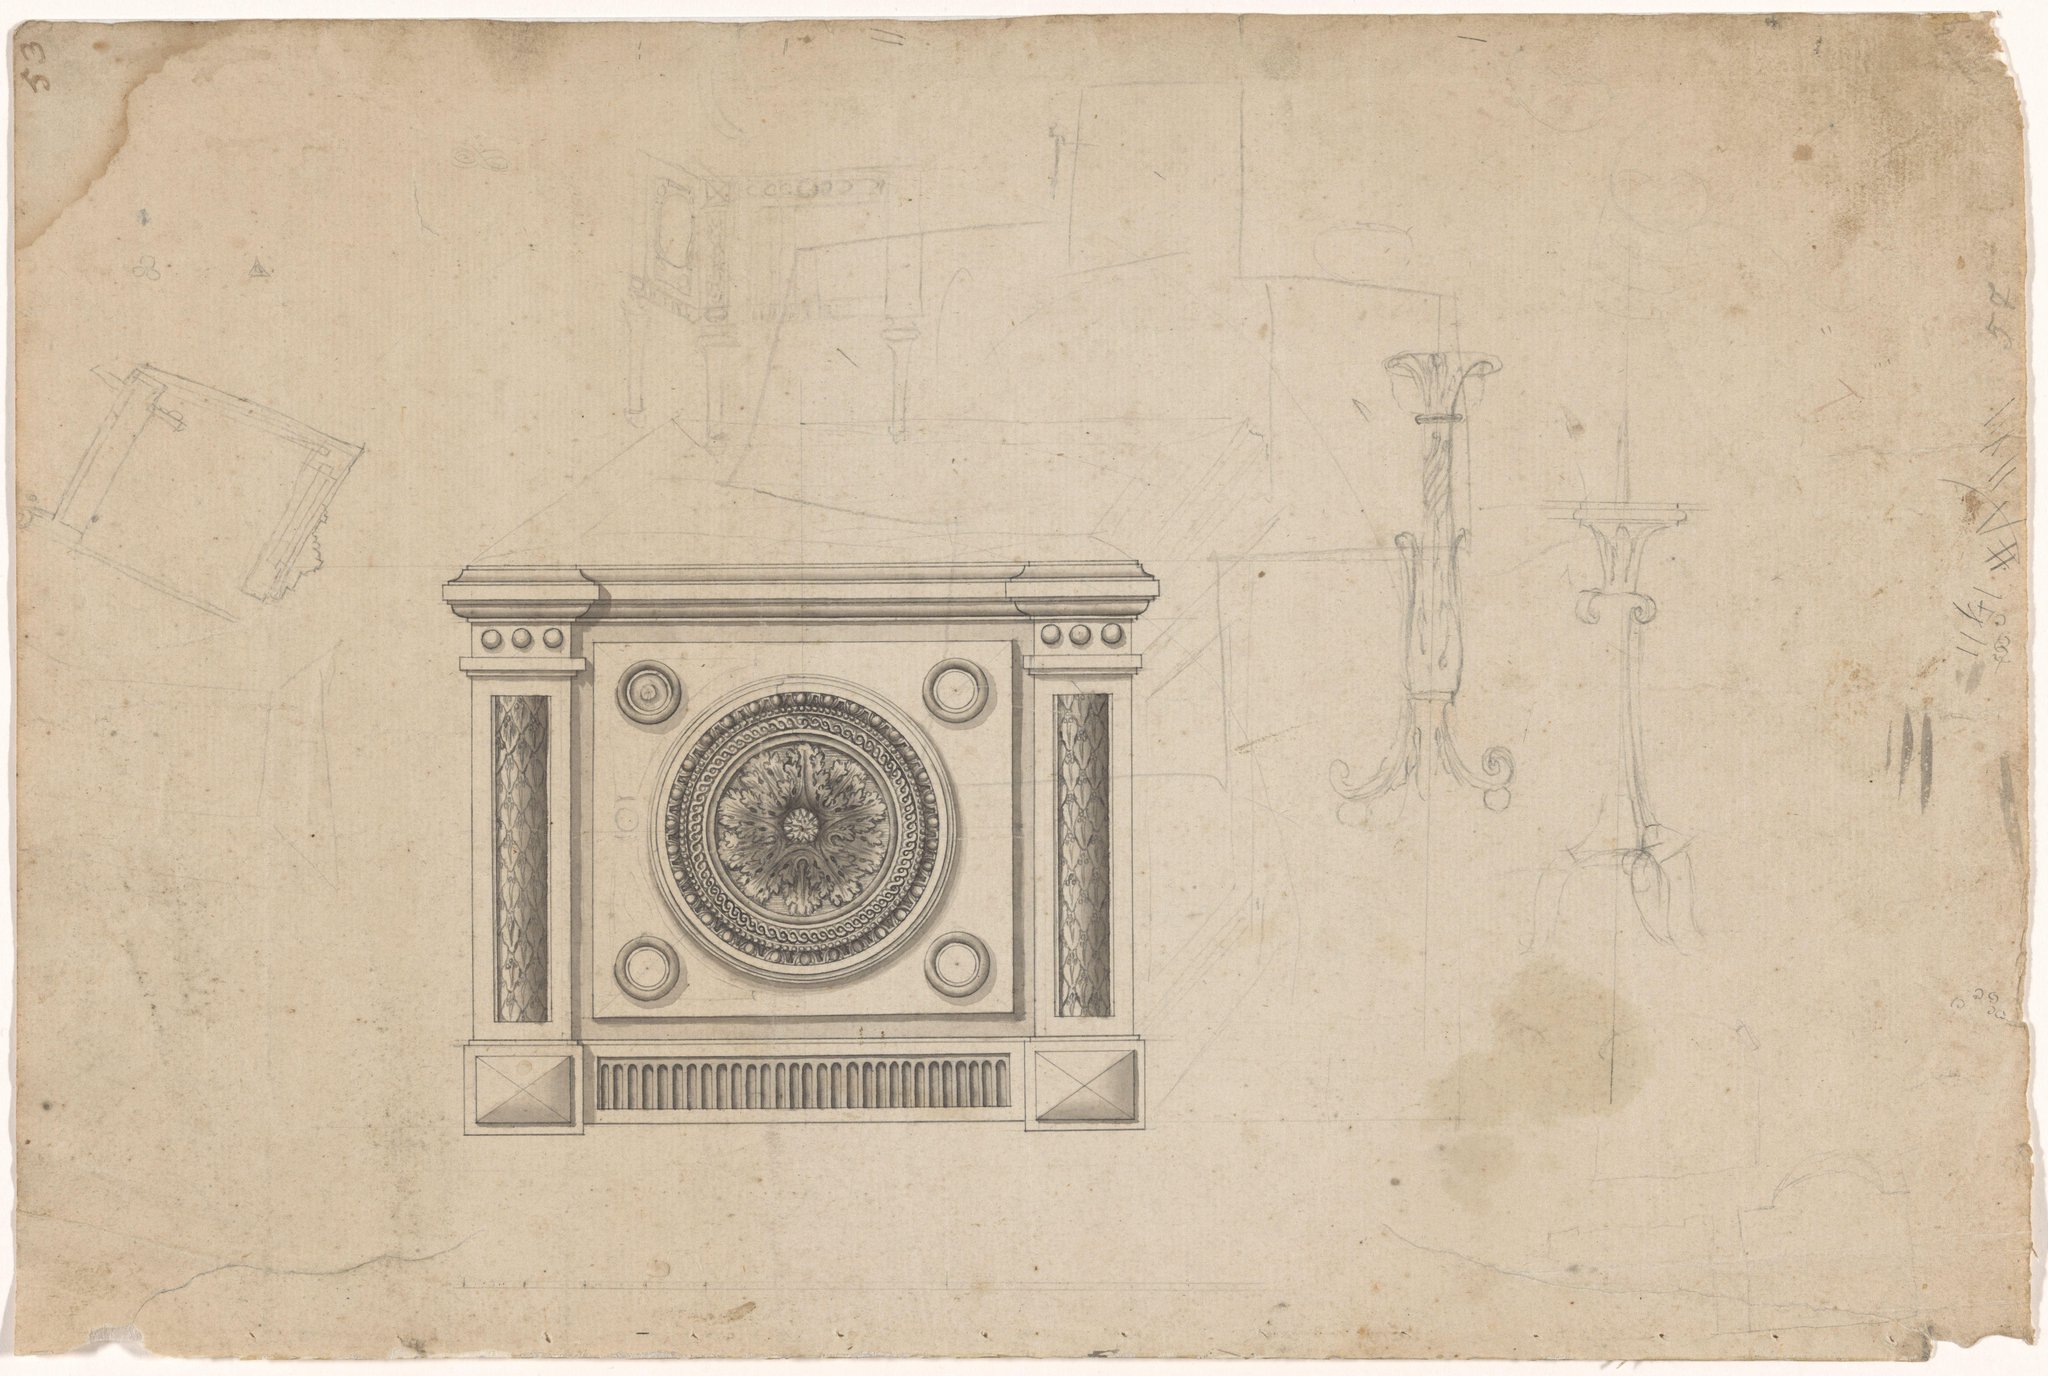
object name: design drawing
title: Ontwerp voor een rechthoekig voetstuk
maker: Anonymous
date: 1780-1790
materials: graphite, ink, paper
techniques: brush, pen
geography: germany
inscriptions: number: ‘53’, watermark: ‘[..] HOONIG / & / ZOONEN’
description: Ontwerp voor een rechthoekig voetstuk met een rozet. Daarbij schetsen van een commode, twee torchères en enkele plattegronden. Verso details van een plattegrond en schetsen van meanderranden.